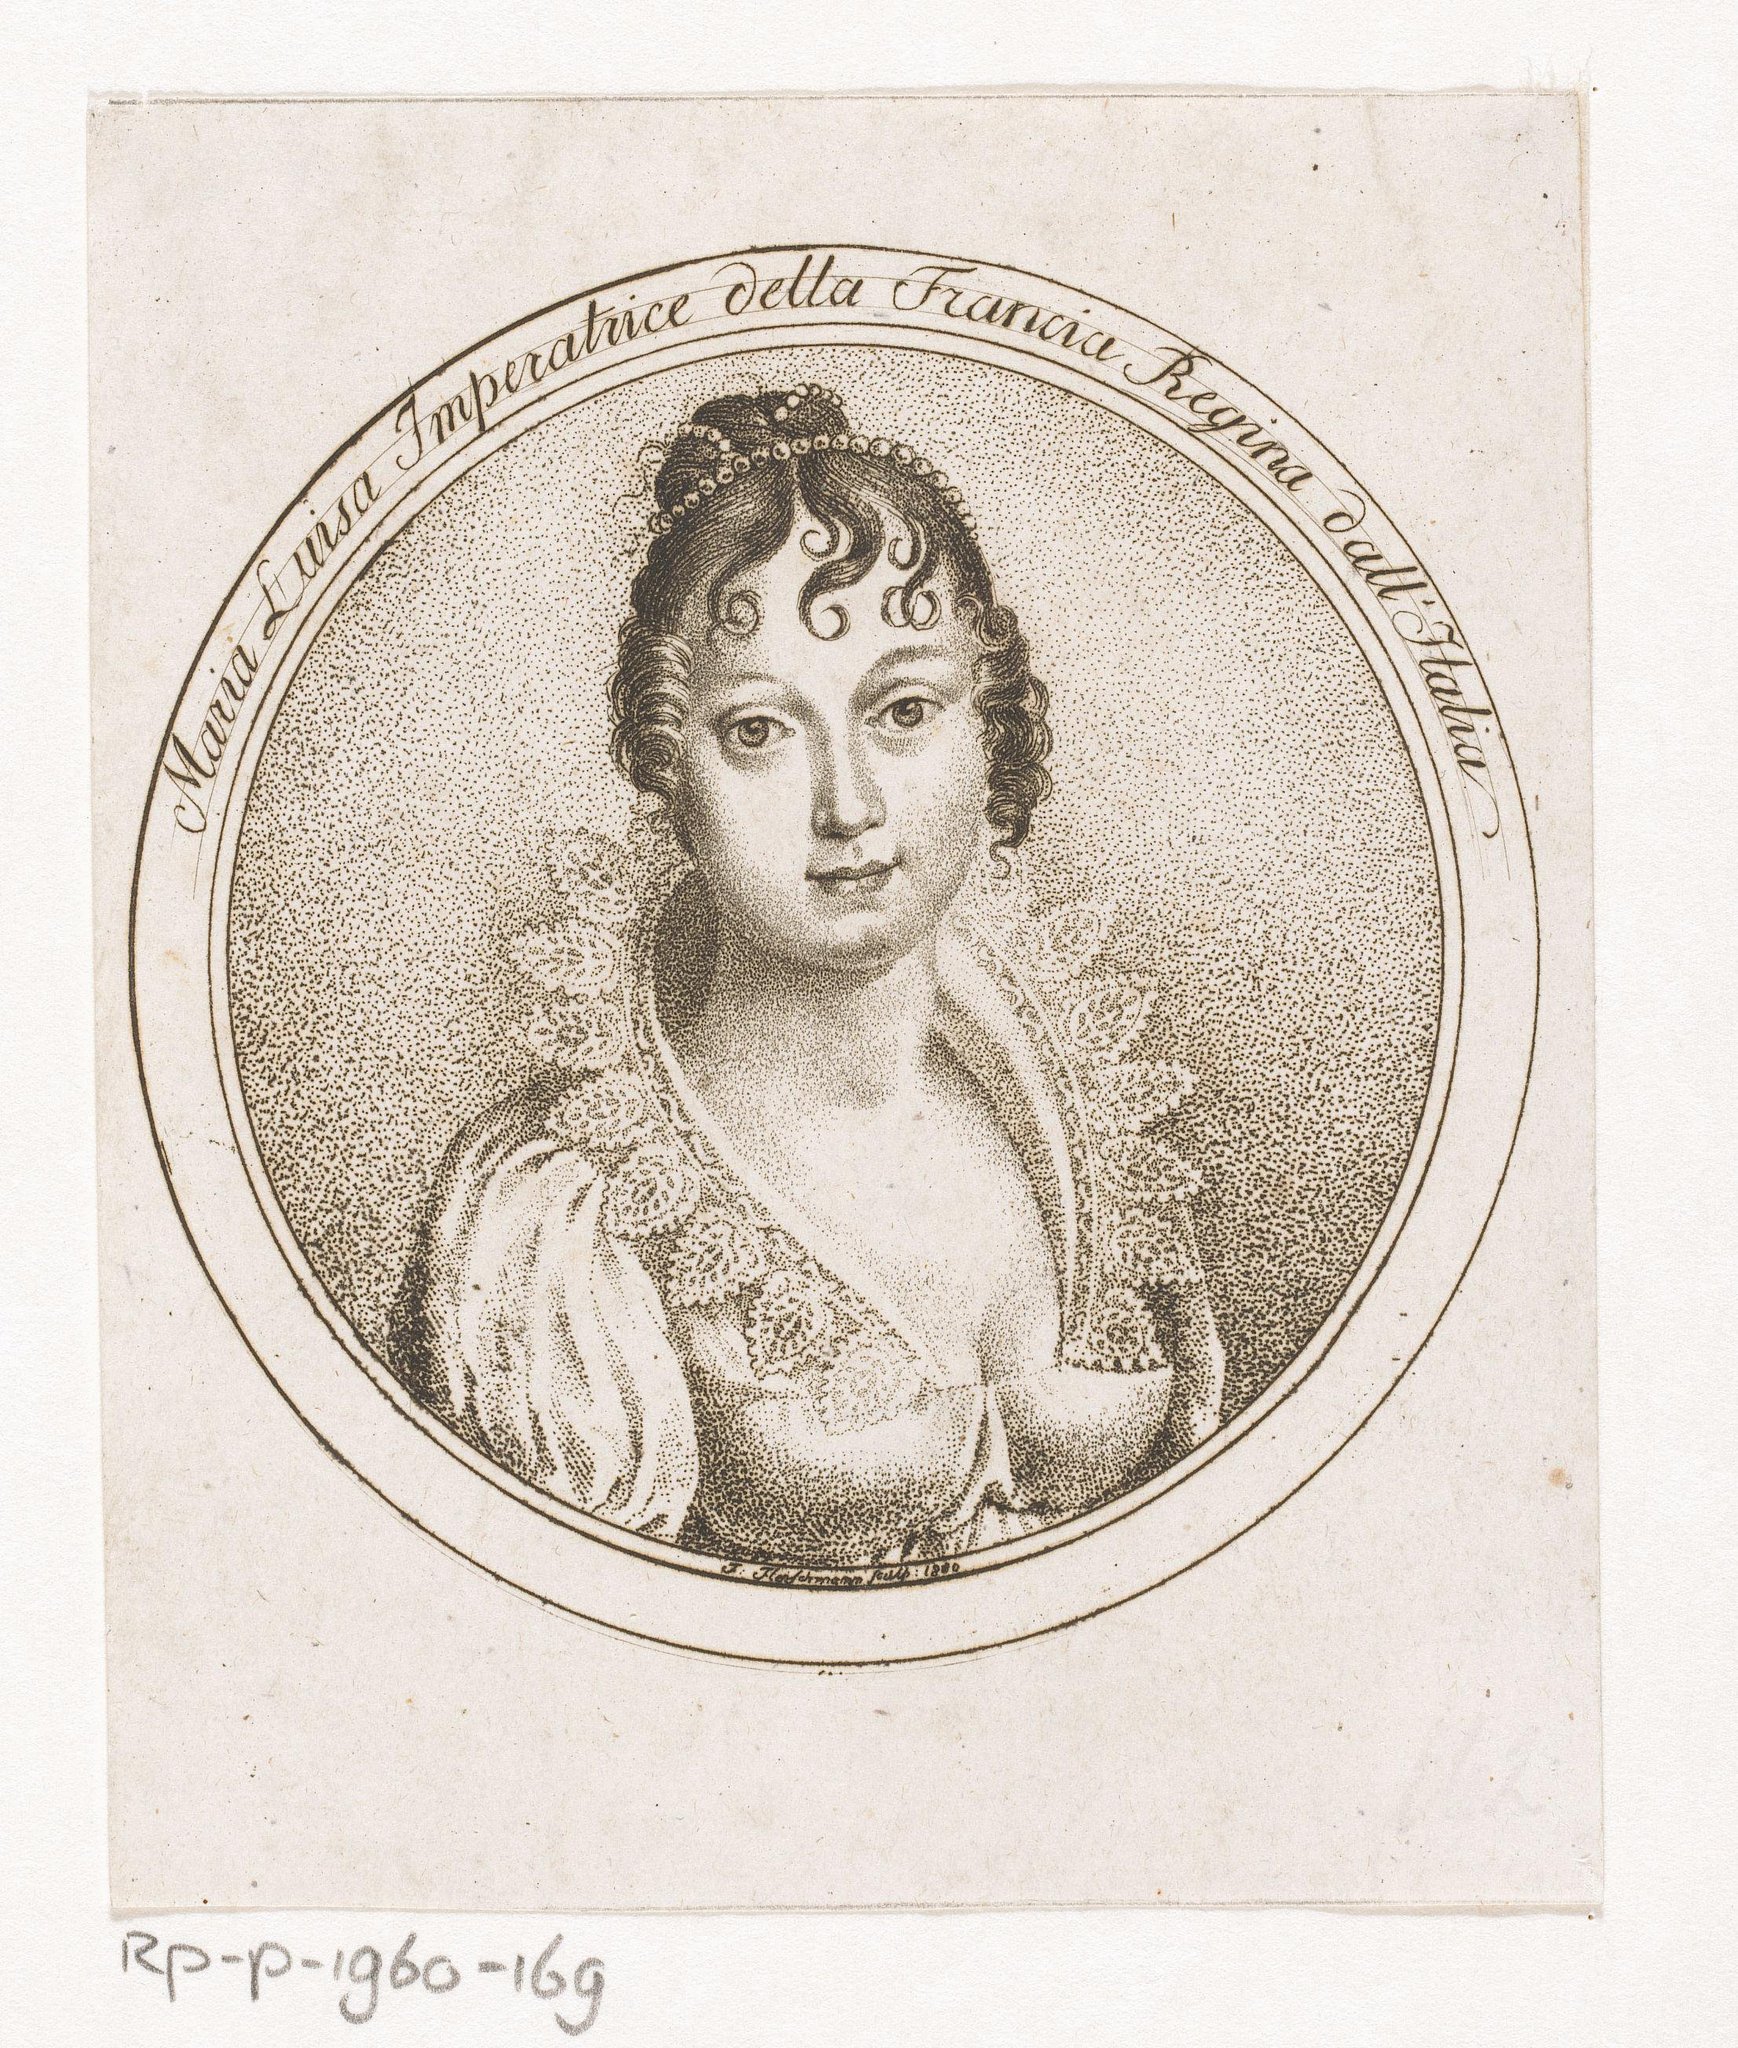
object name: print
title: Portret van Marie Louise van Oostenrijk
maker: friedrich fleischmann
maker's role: print maker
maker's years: 1791-1834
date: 1820-1830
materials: paper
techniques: stippling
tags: vienna, marie louise van oostenrijk (keizerin der fransen), historical persons - bb - woman, ruler, sovereign - bb - female ruler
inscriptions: collector's mark: Lugt 2228